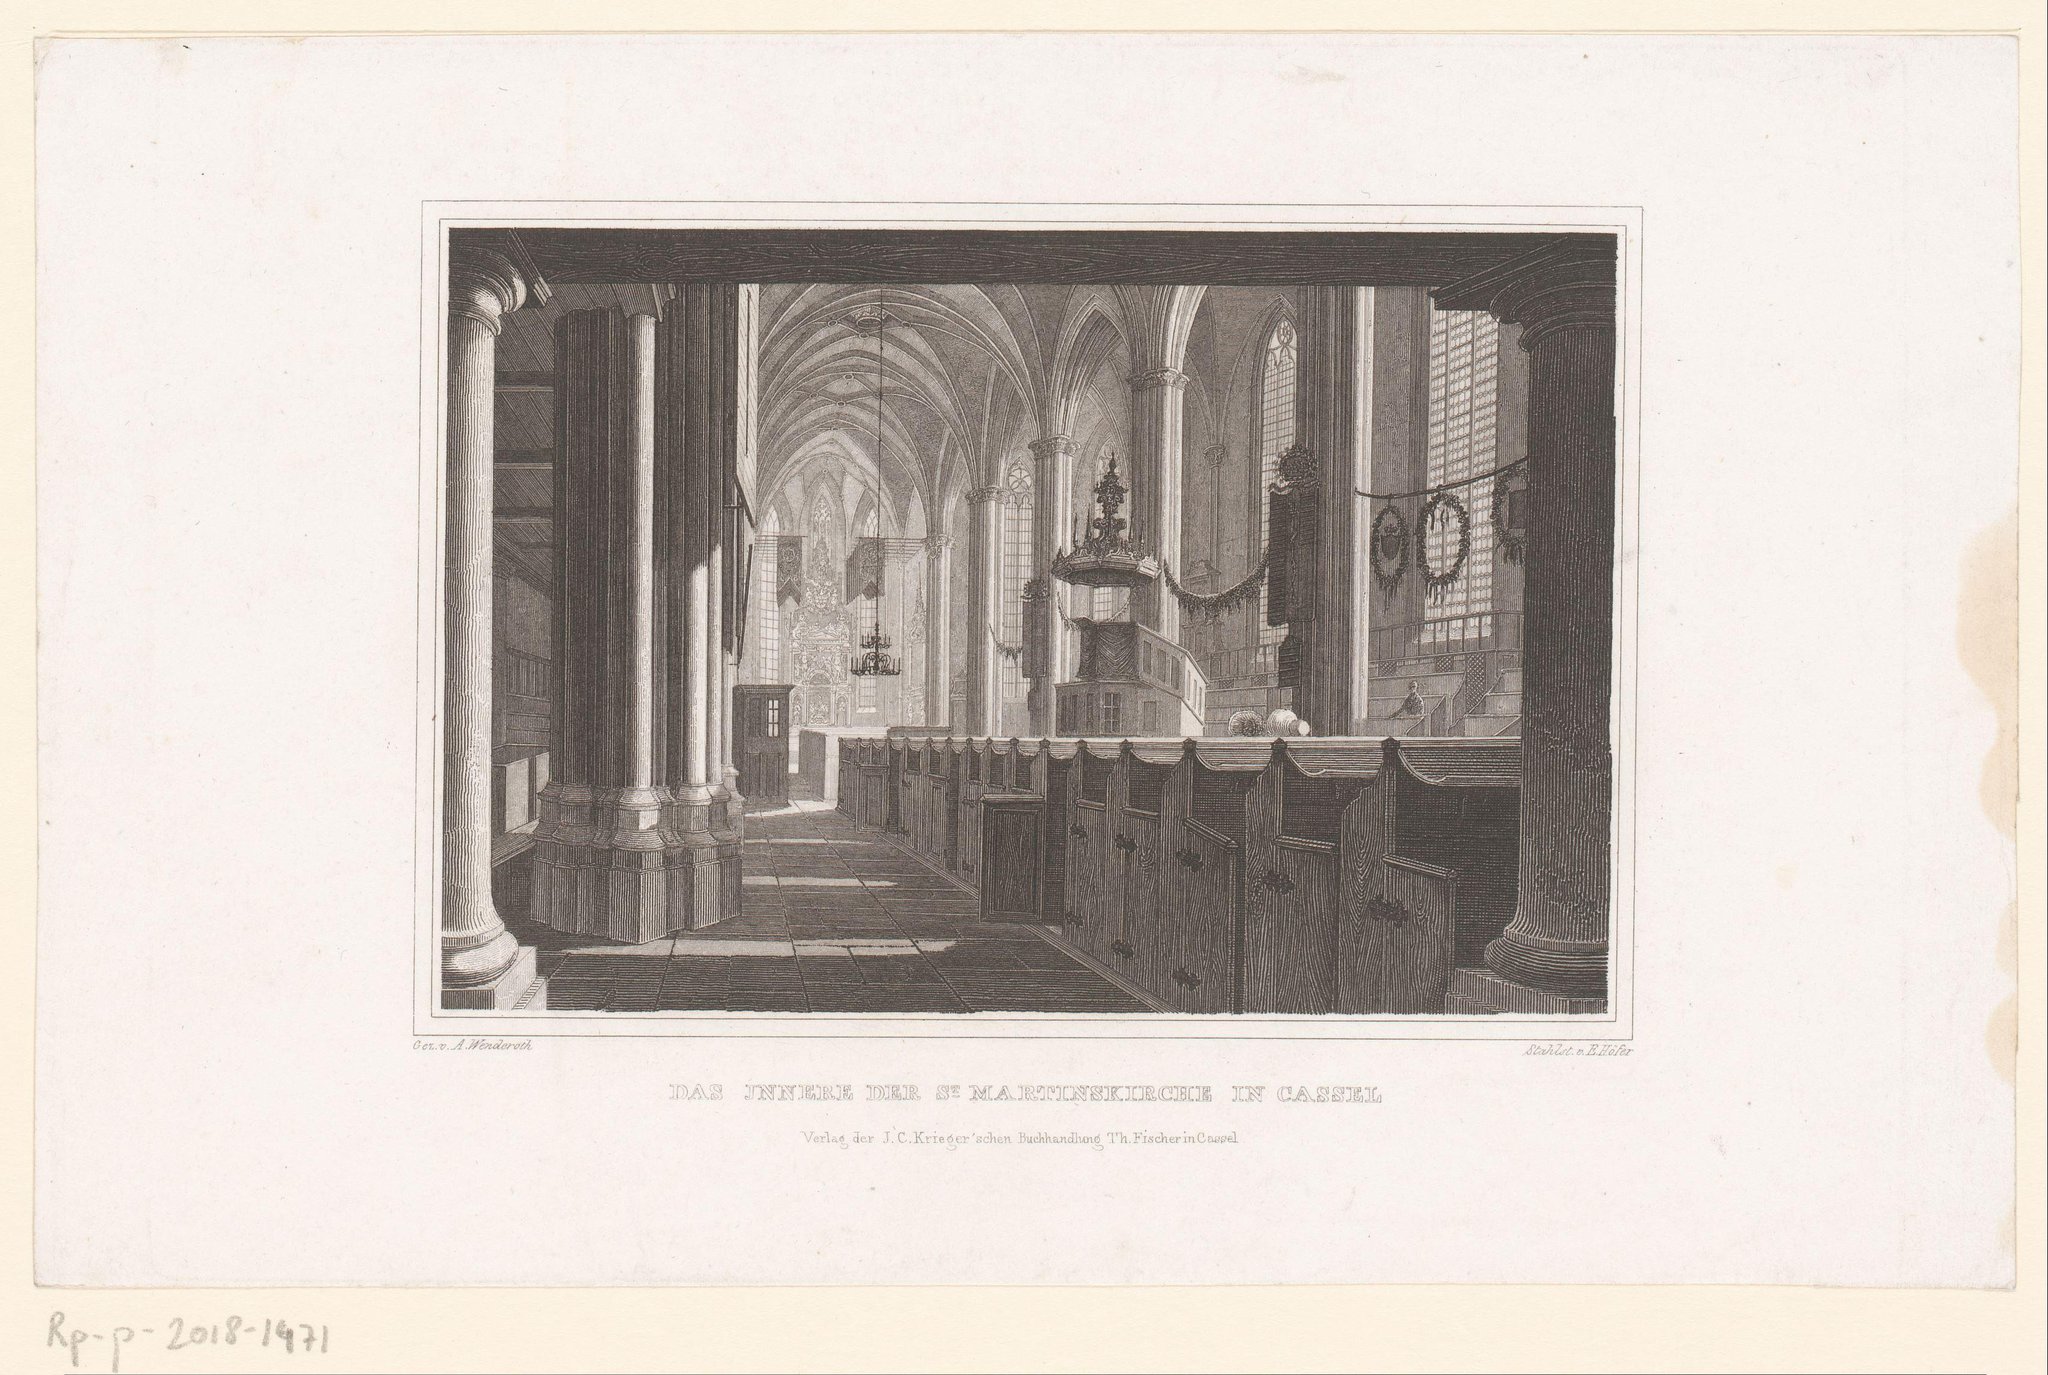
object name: print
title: Interieur van de Martinuskerk, te Kassel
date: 1831-1863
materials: paper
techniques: engraving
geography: kassel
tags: interior of church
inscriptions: collector's mark: Lugt 2228